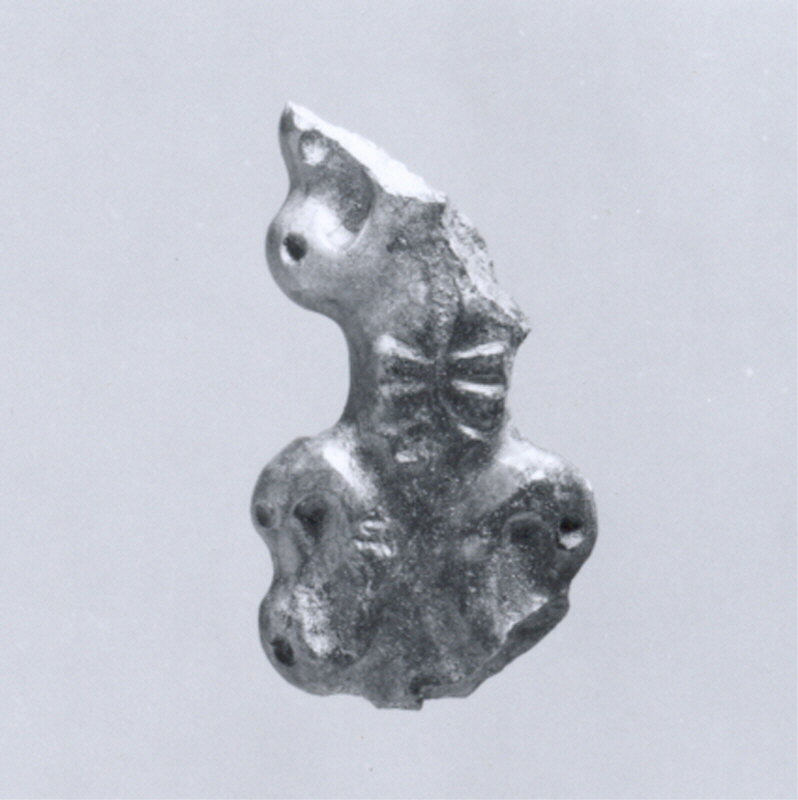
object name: harness or bridle fitting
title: Harness or bridle fitting (?)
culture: iranian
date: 900-801 BCE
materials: shell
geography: iran